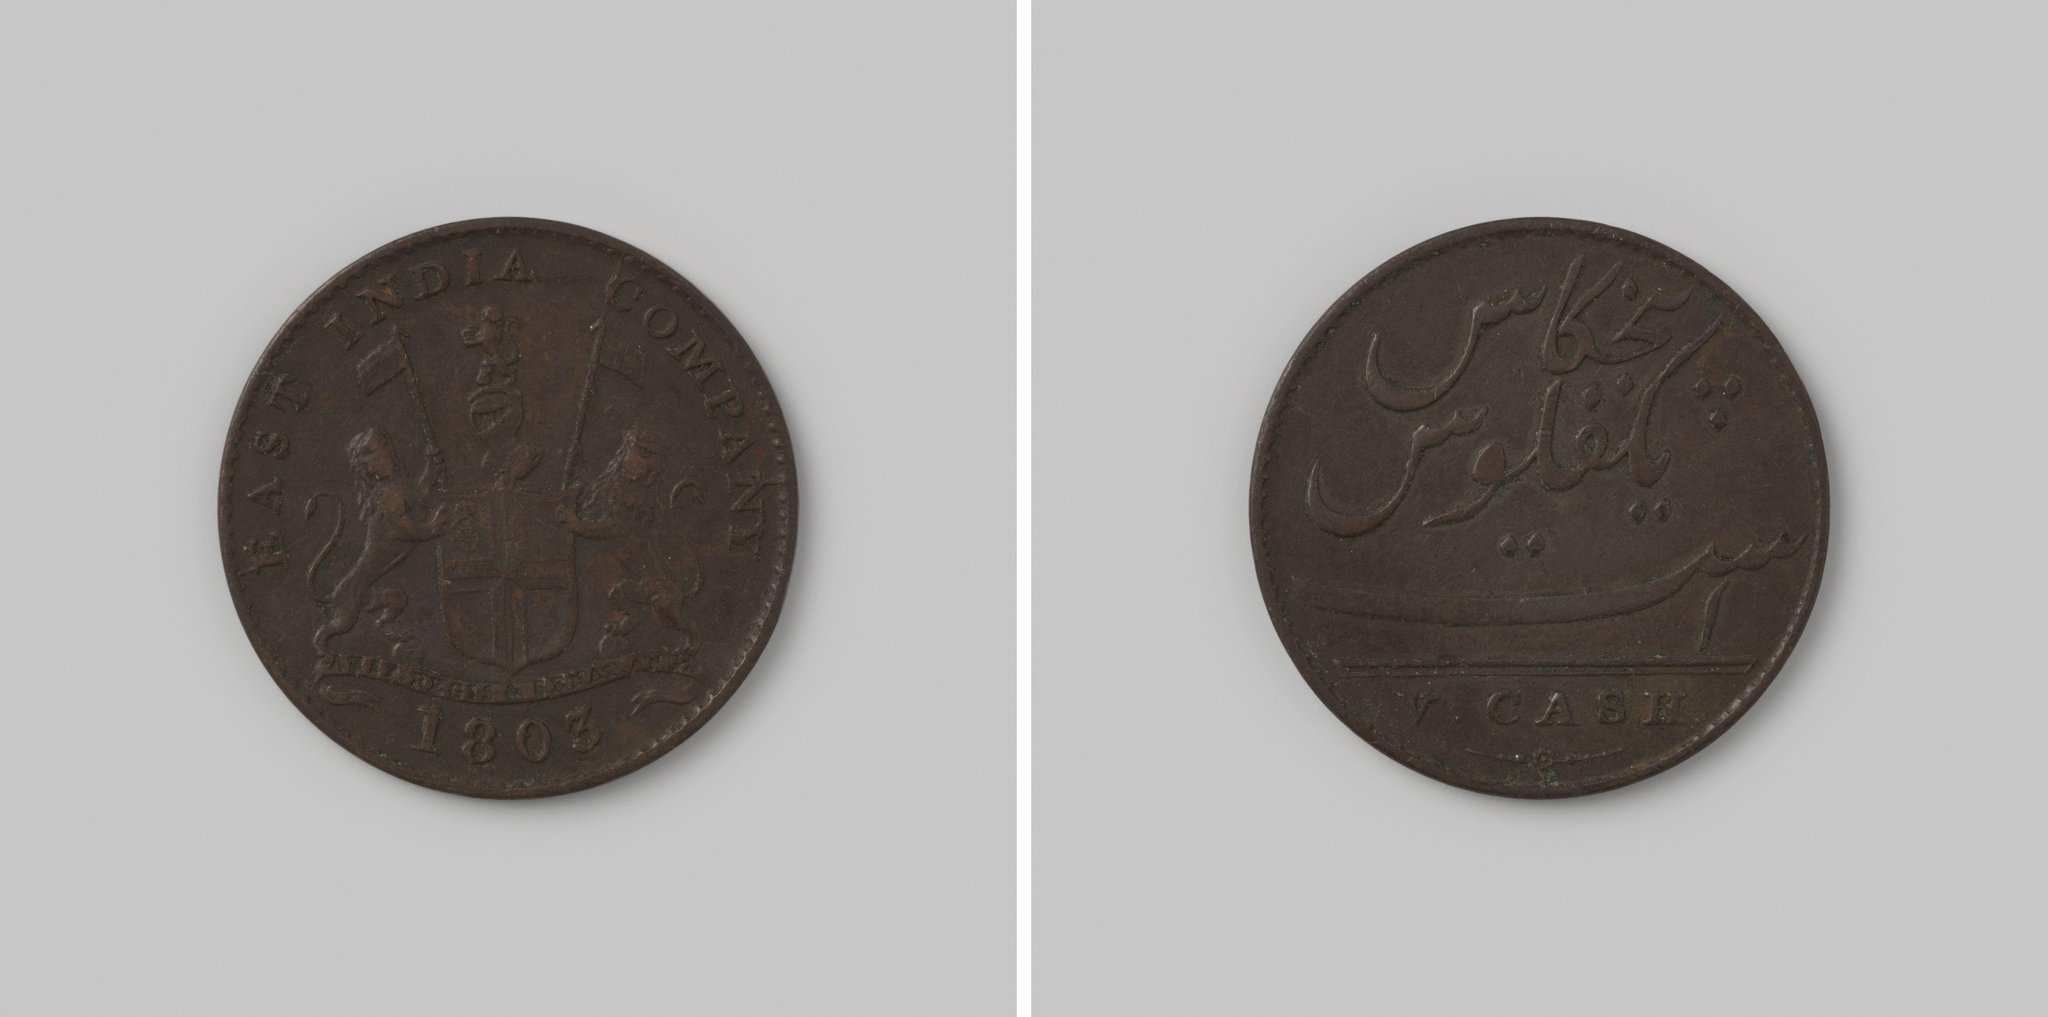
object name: coin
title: 5 cash voor Madras in India van de Engelse Oostindische Compagnie (EIC), 1803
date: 1803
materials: copper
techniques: striking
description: Koperen munt. Voorzijde: door twee op banderol, waarin opschrift, staande leeuwen met pijl, waaraan vlag in de klauw, gehouden wapenschild van de EIC, waarboven helmteken. Jaartal onderaan. Keerzijde: in Arabische lettertekens opschrift in drie regels. In afsnede waarde-aanduiding: V Cash. Gladde rand.